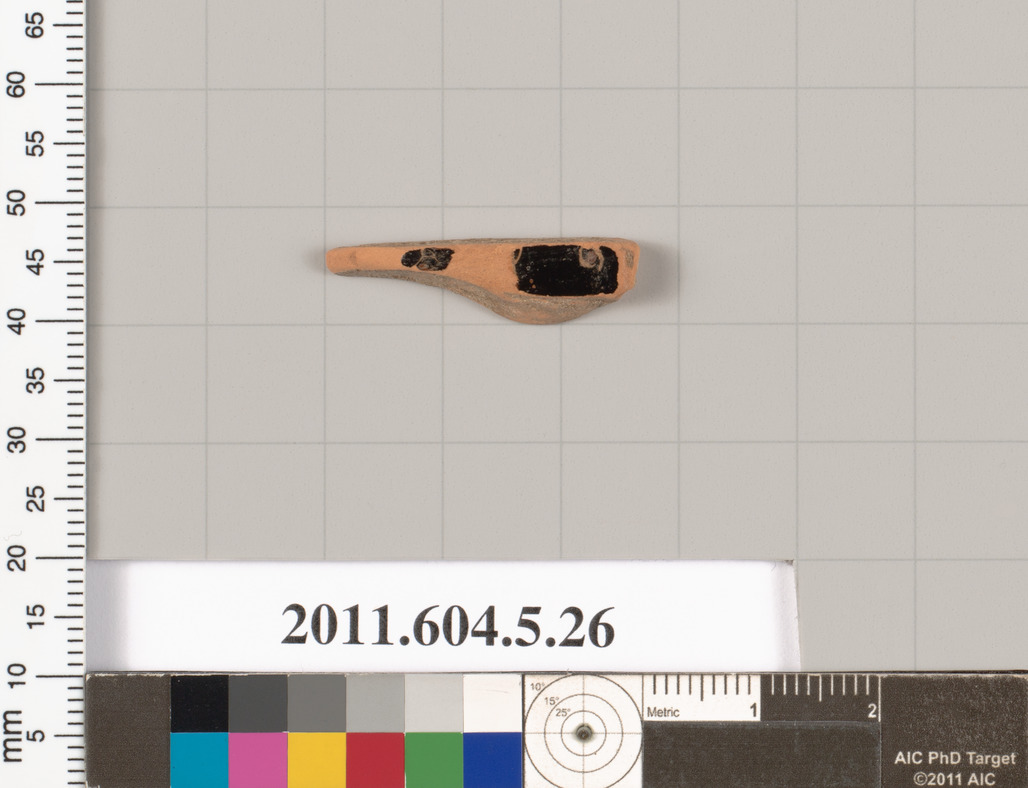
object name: kylix fragment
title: Terracotta fragment of a kylix (drinking cup)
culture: greek, attic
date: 534-501 BCE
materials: terracotta